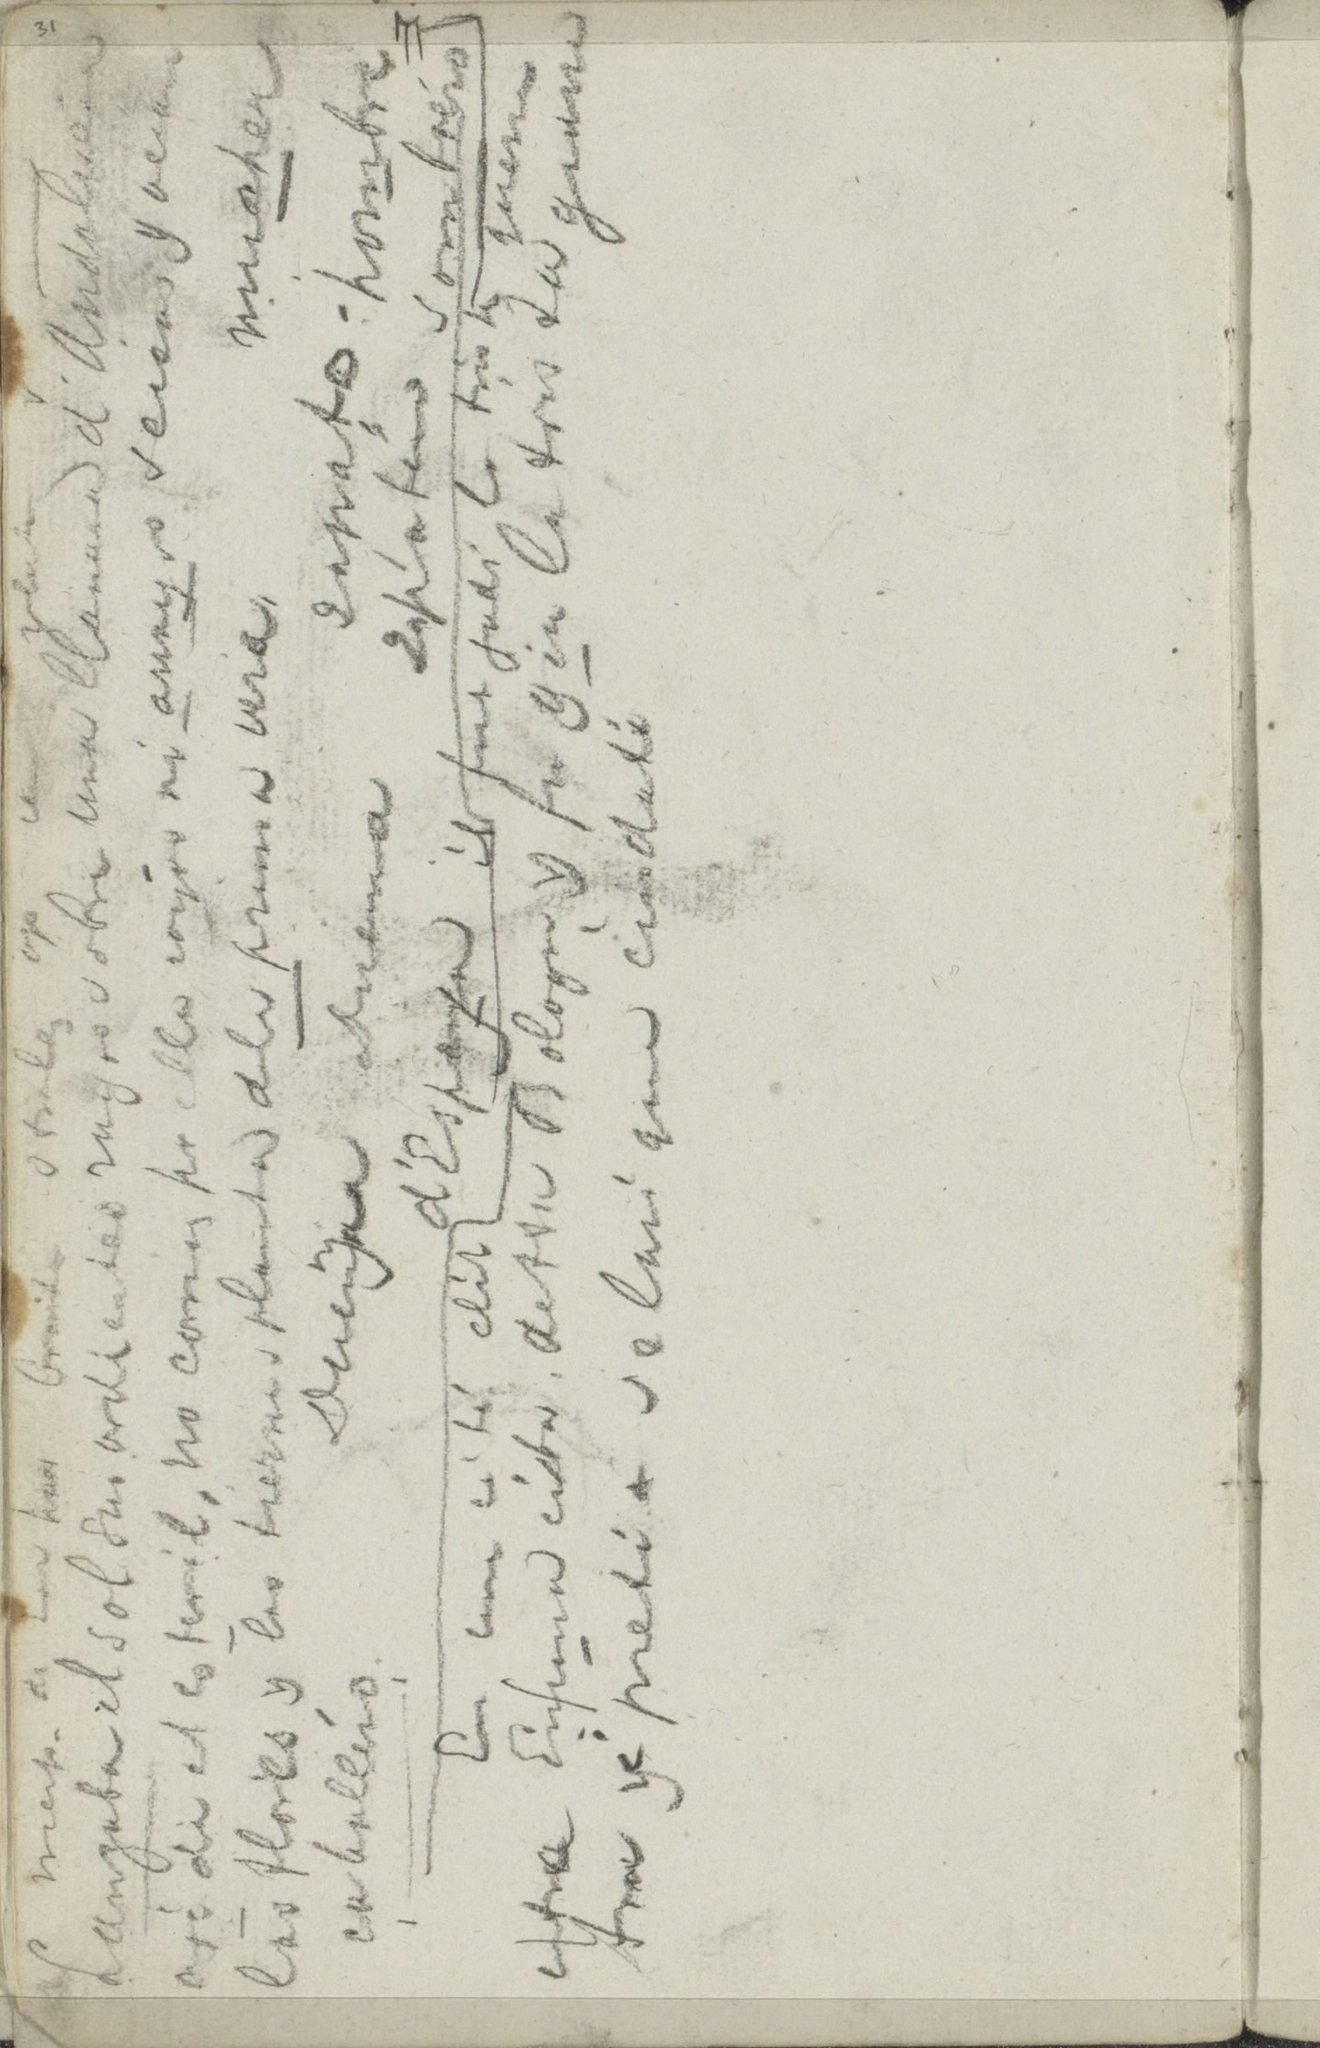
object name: sketchbook leaf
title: Spaanstalige en Franstalige tekst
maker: george hendrik breitner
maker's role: draughtsman, painter, print maker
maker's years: 1857-1923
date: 1883-1885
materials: chalk, paper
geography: the hague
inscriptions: inscription: ‘[...]’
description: Pagina 31 uit een schetsboek met 17 bladen.